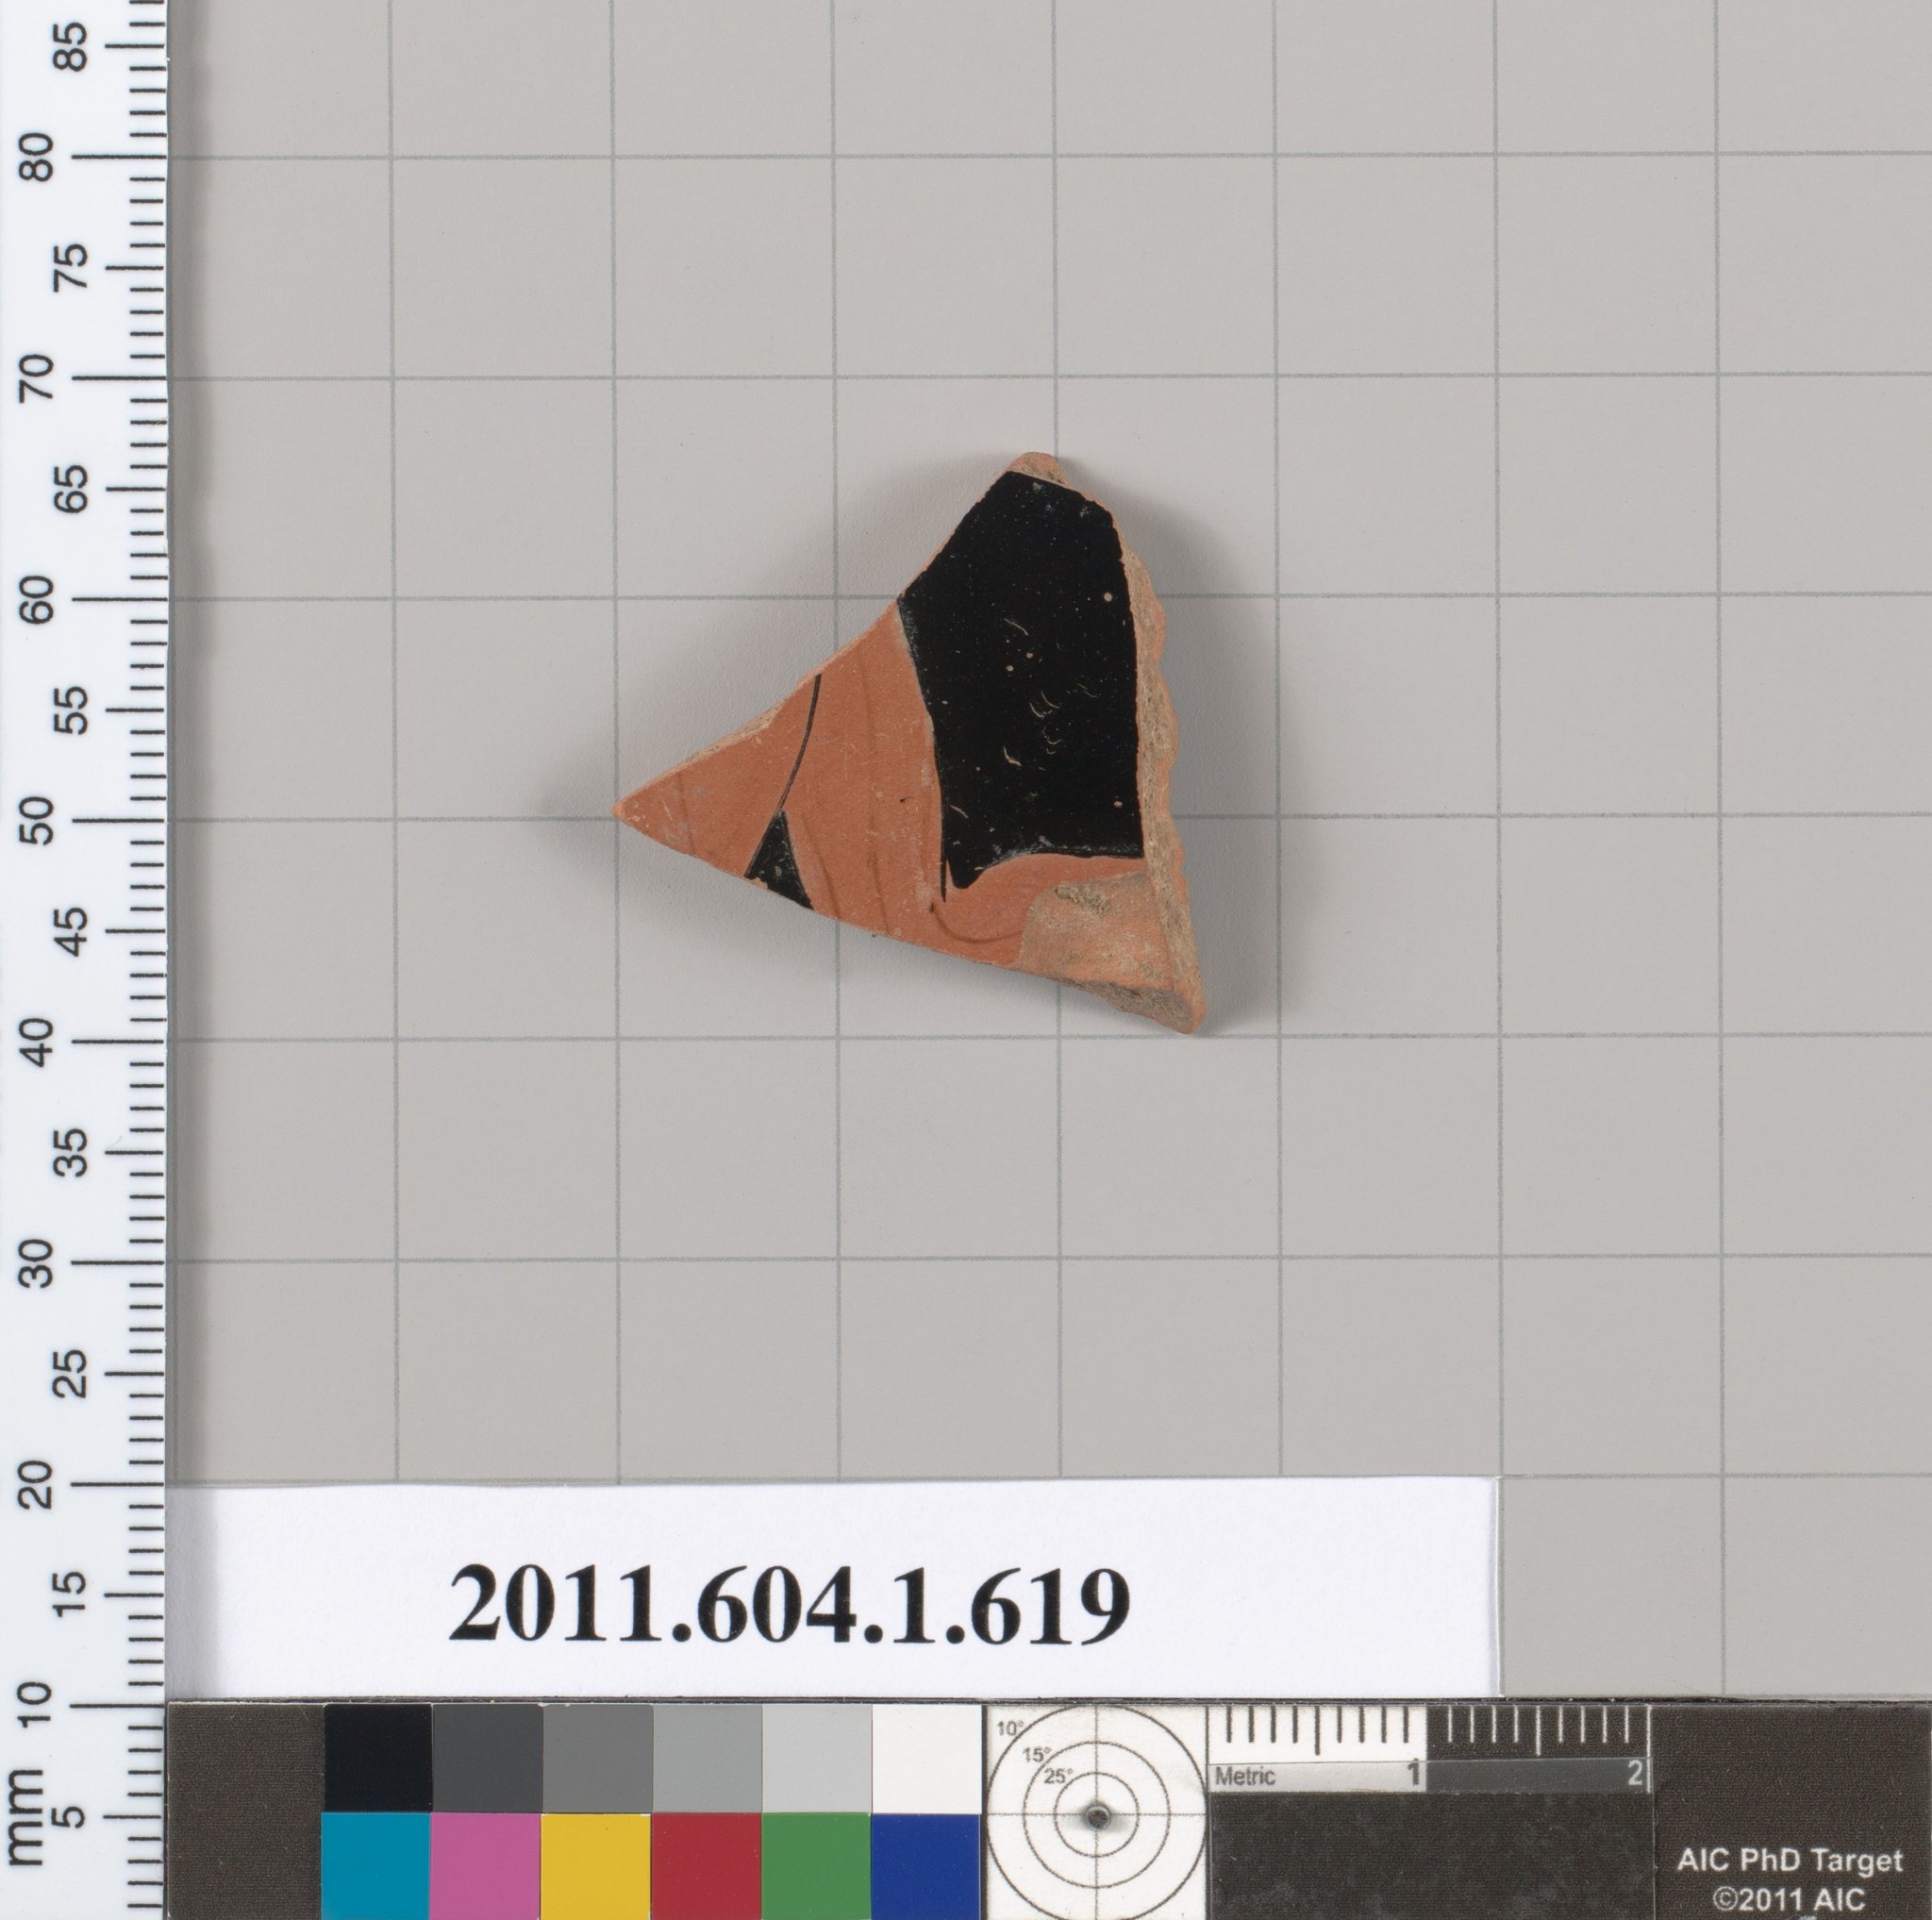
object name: kylix fragment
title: Terracotta fragment of a kylix (drinking cup)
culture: greek, attic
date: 534-501 BCE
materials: terracotta